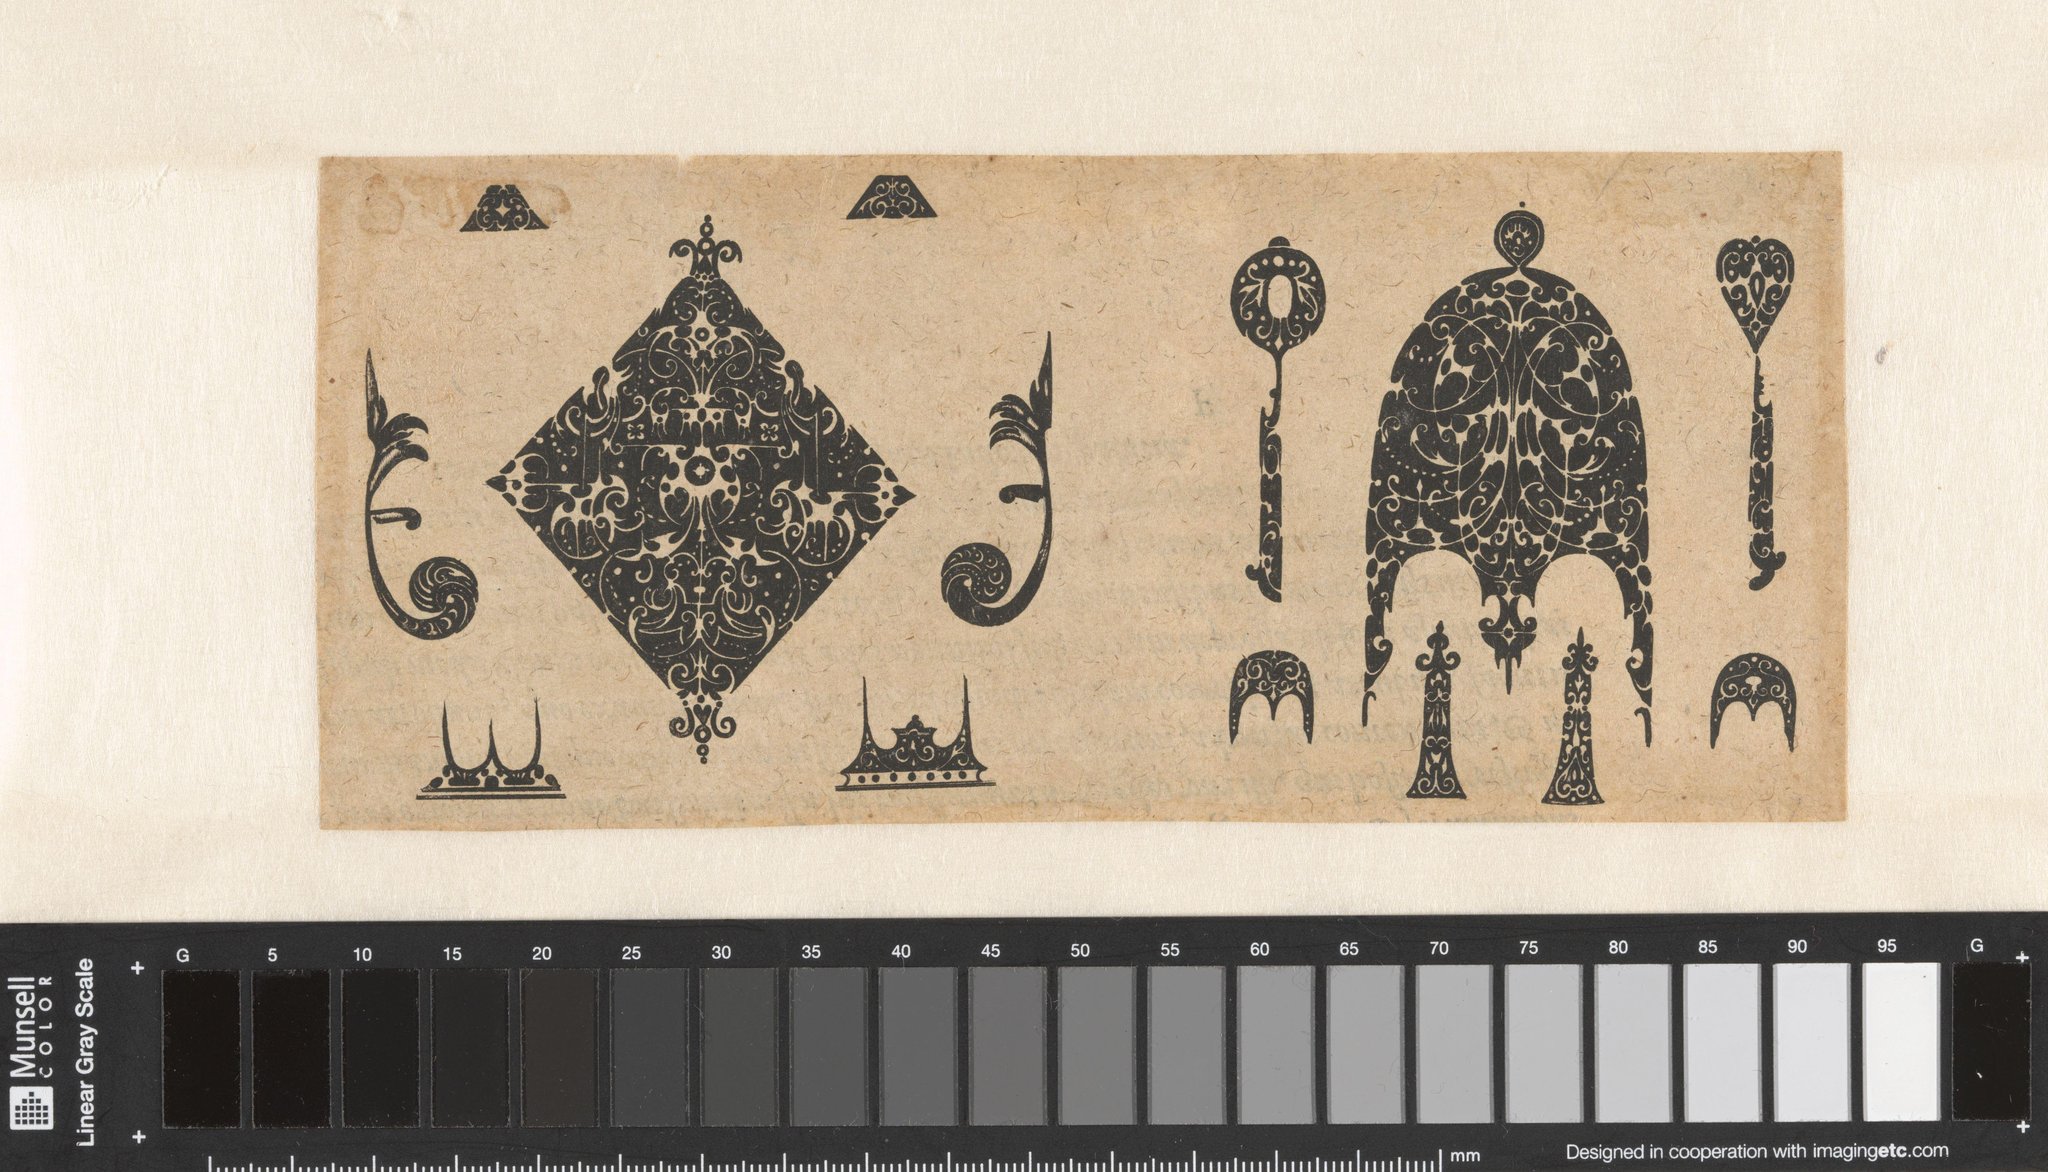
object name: print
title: Twee zwartornamenten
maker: guillaume de la quewellerie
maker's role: print maker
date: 1610-1635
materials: paper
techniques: engraving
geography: amsterdam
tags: ornaments ~ art, ornaments, jewels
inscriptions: :, collector's mark: Lugt 2760, collector's mark: Lugt 2228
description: Twee ontwerpen voor sieraden in zwartornament.